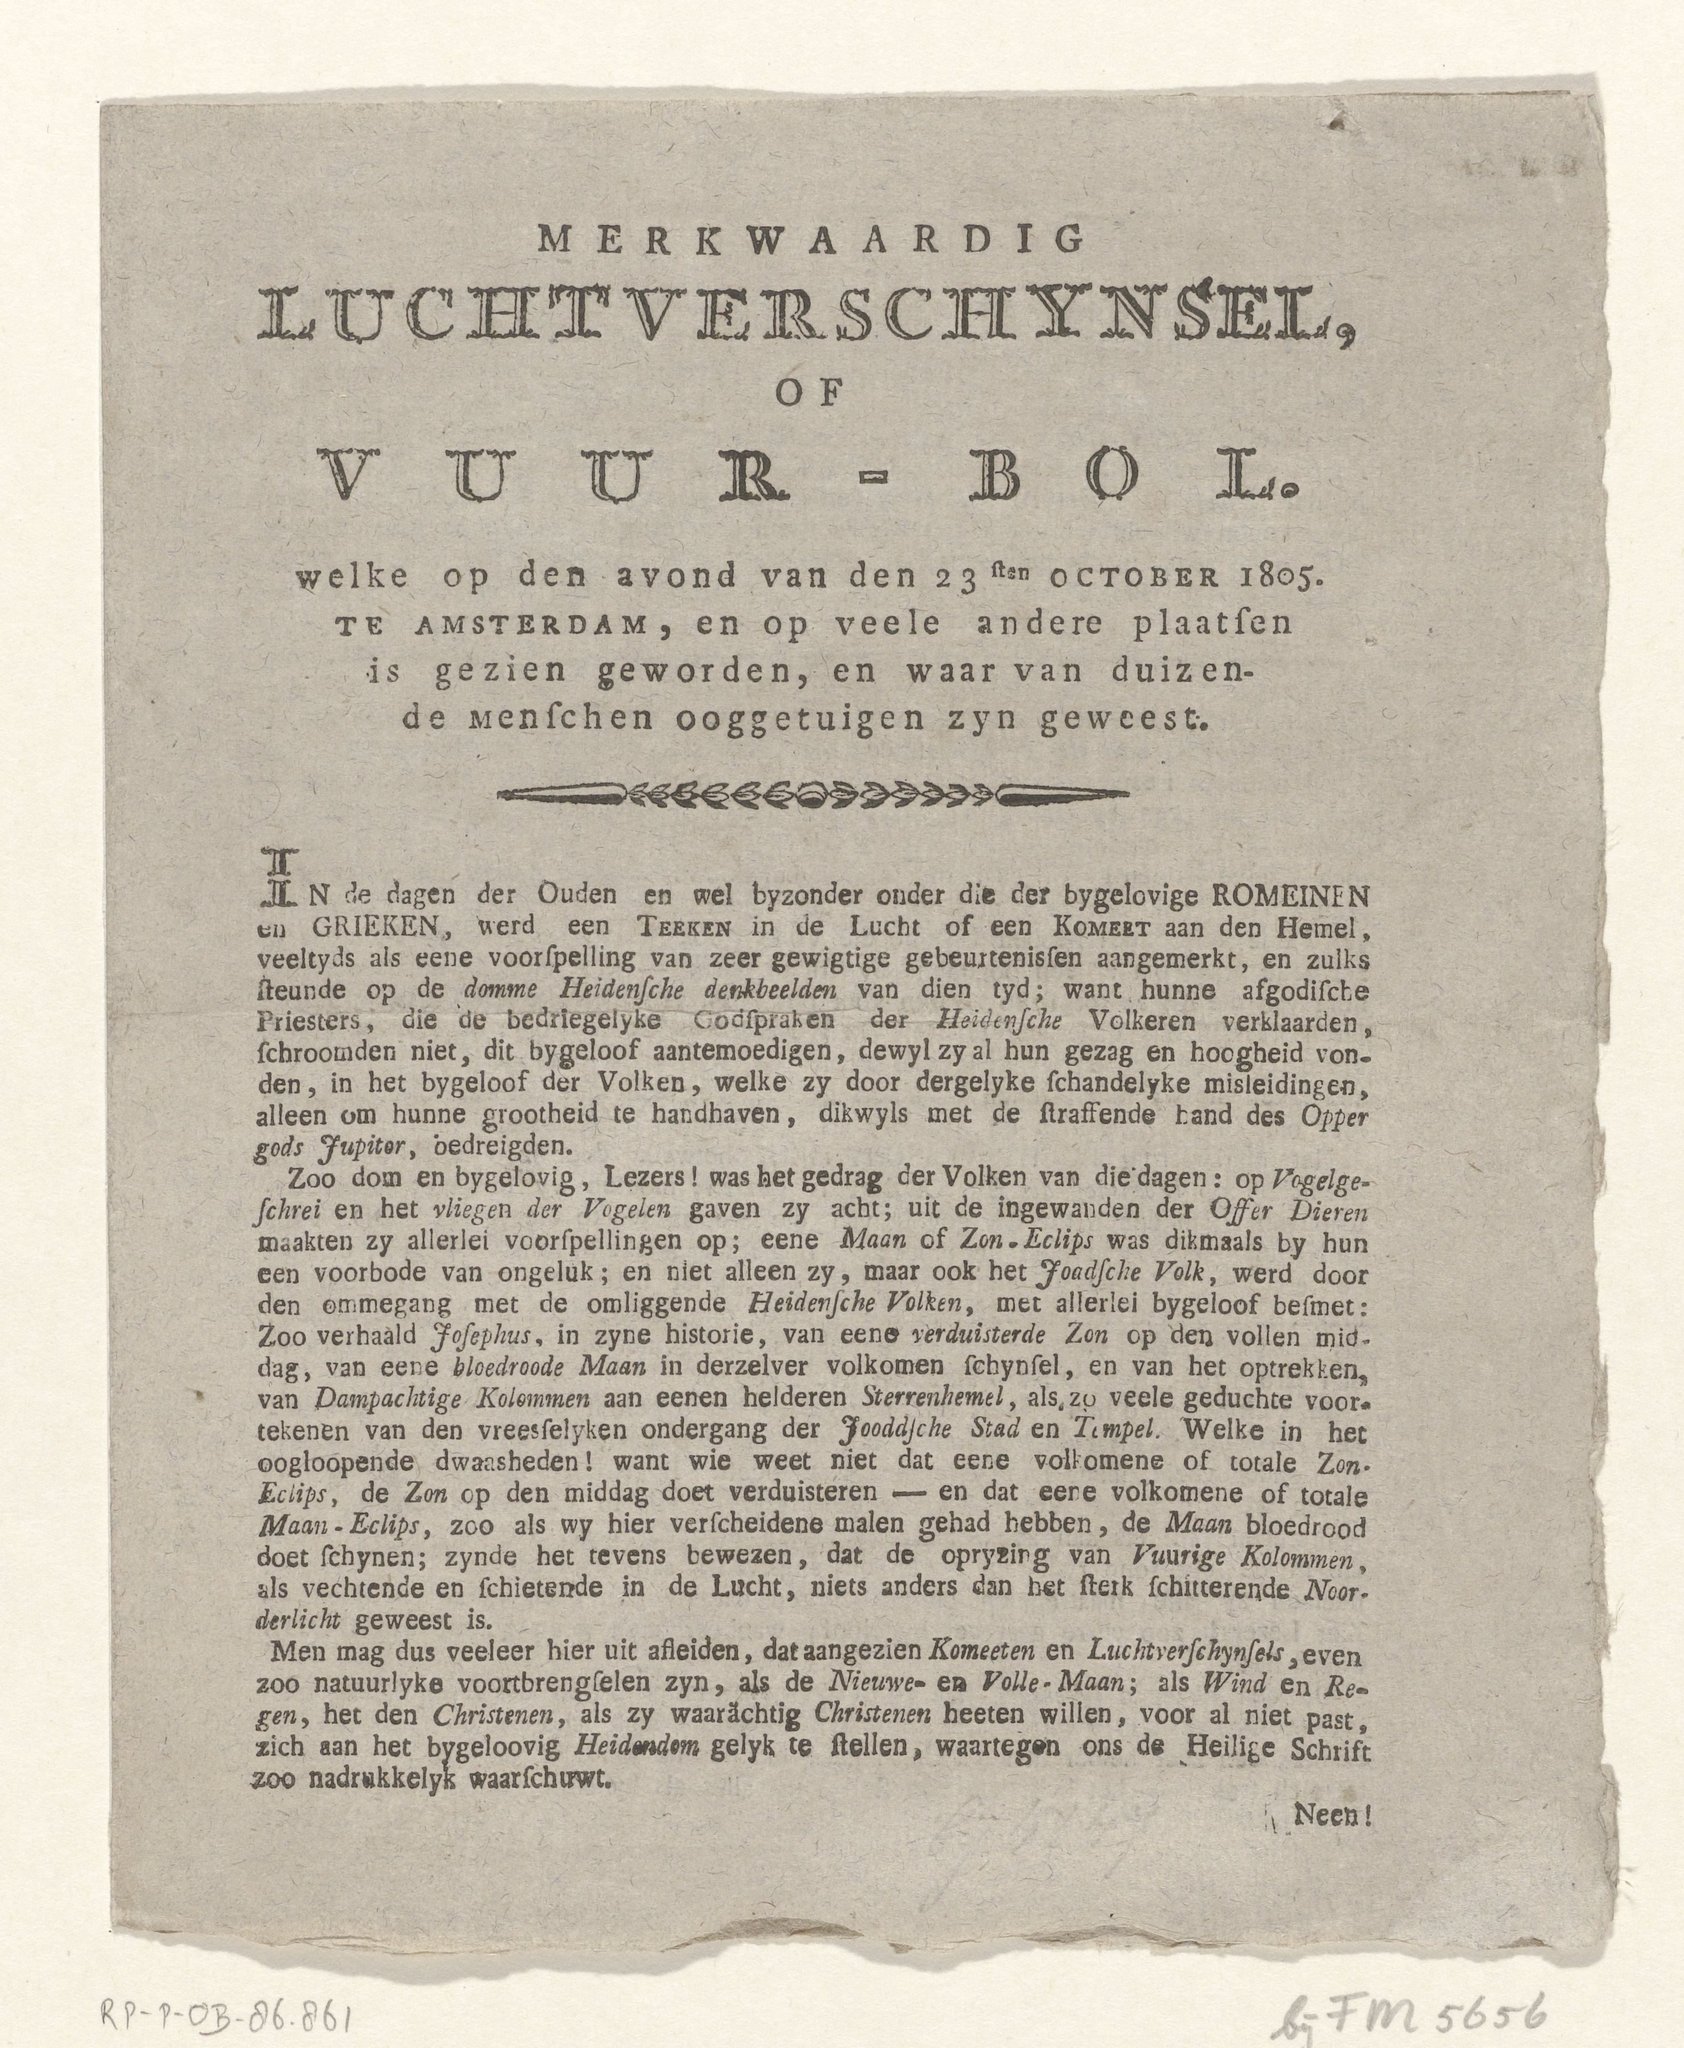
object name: text sheet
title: Pamflet over het luchtverschijnsel te Amsterdam, 1805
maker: martinus van kolm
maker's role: printer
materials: paper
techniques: letterpress printing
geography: amsterdam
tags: good and bad weather, astronomical phenomena, amsterdam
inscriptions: collector's mark: Lugt 2228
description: Pamflet over het merkwaardige luchtverschijnsel dat op de avond van 23 oktober 1805 boven Amsterdam, en andere plaatsen, te zien was. Dubbelgevouwen blad bedrukt op alle vier zijden. Op de laatste zijde een lied.